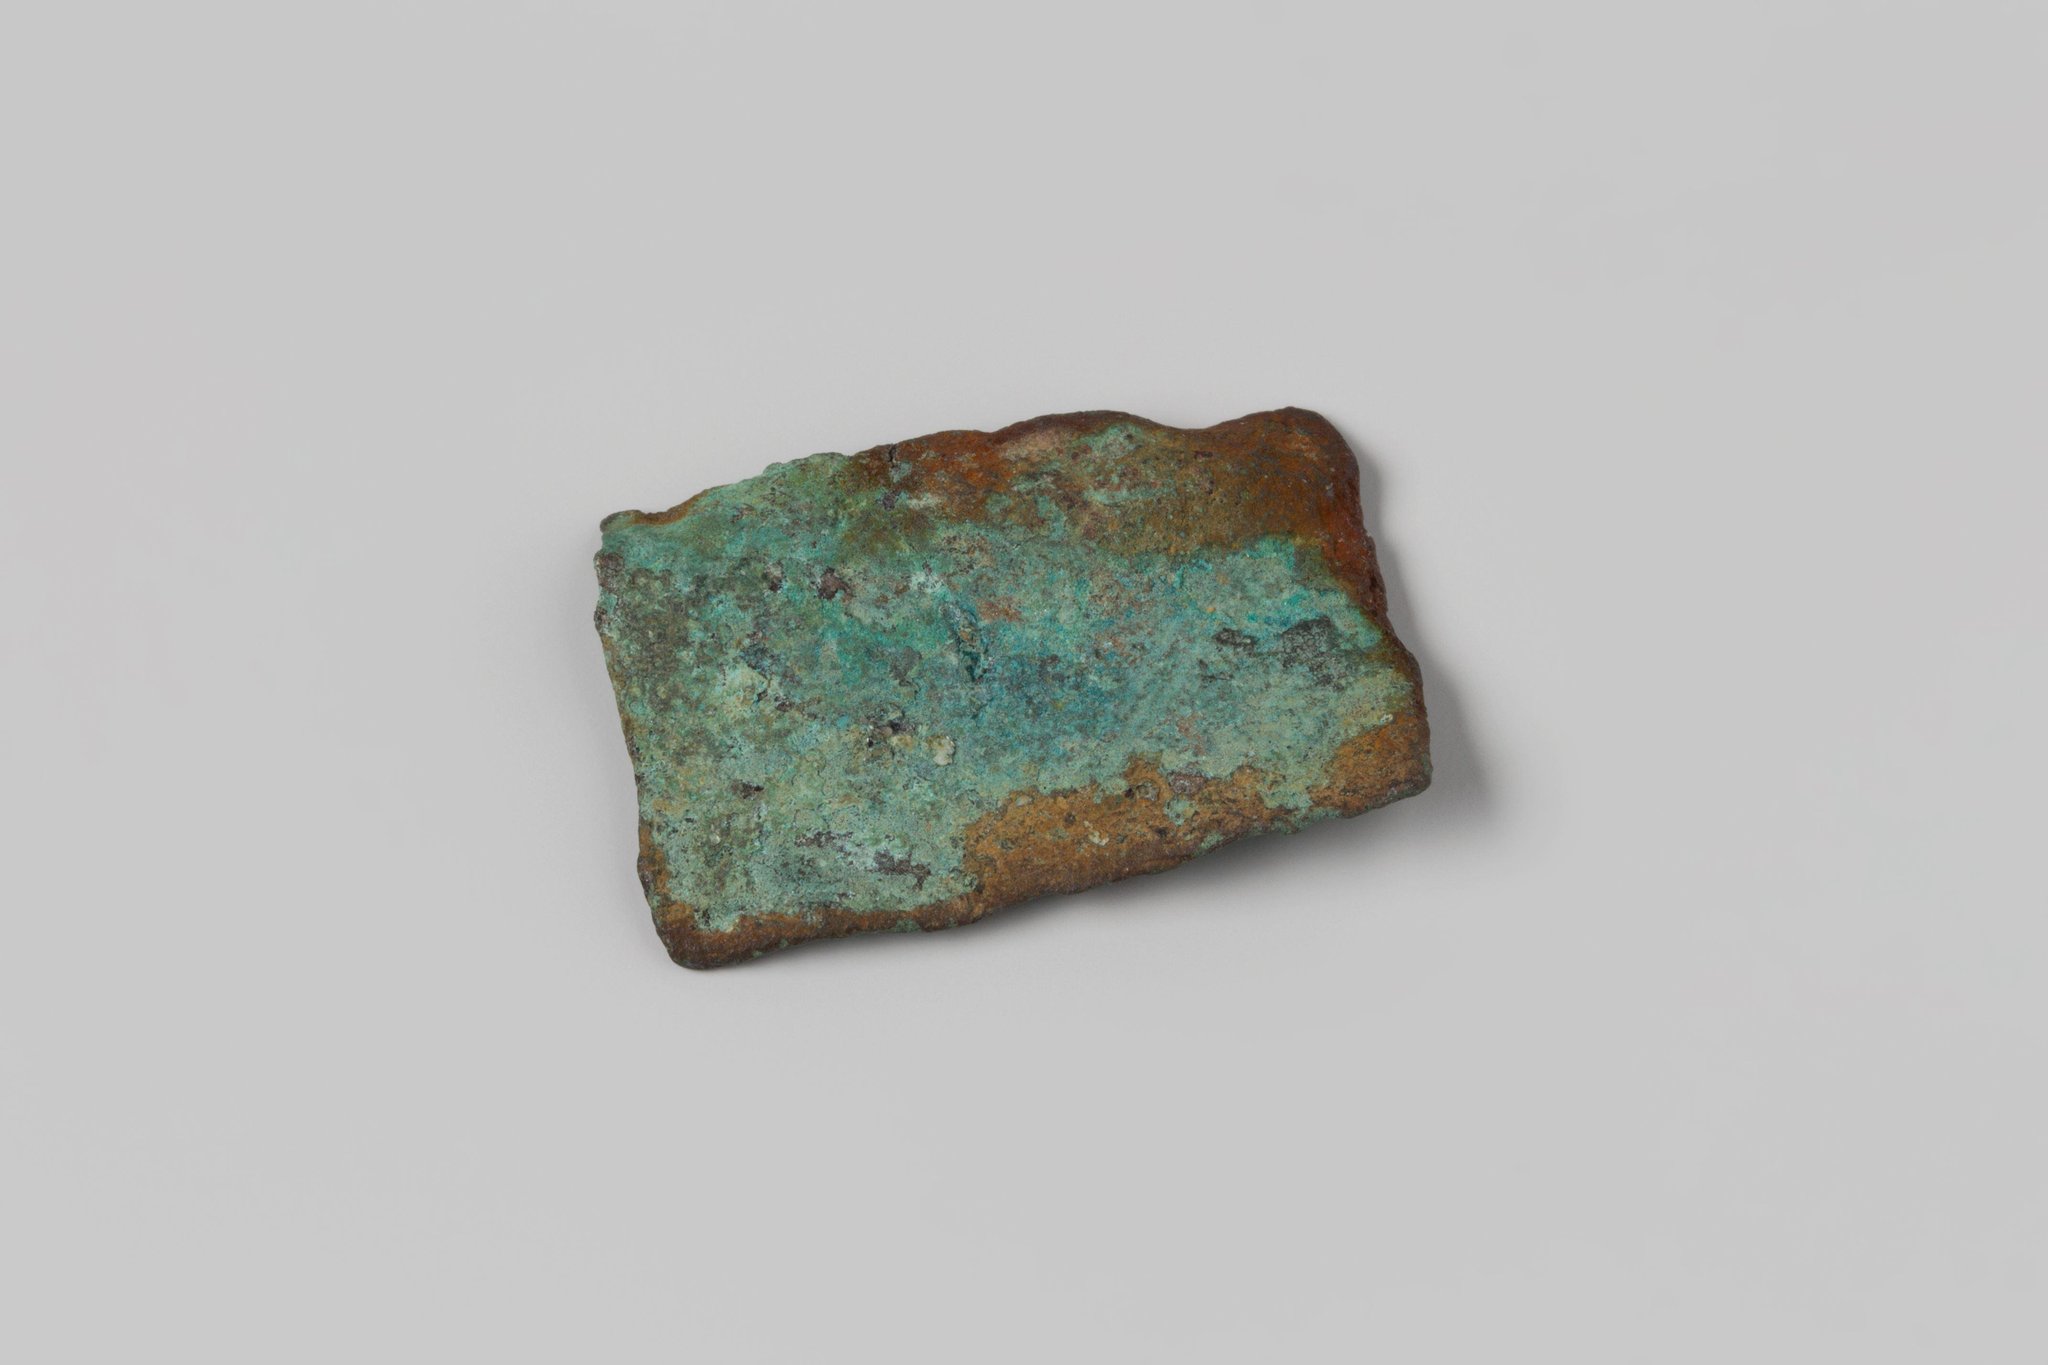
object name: scheepswrakvondst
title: Fragment van koper uit het wrak van de Oost-Indiëvaarder Hollandia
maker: Anonymous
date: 1700-1743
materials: copper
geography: netherlands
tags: verenigde oostindische compagnie, hollandia (schip), annet